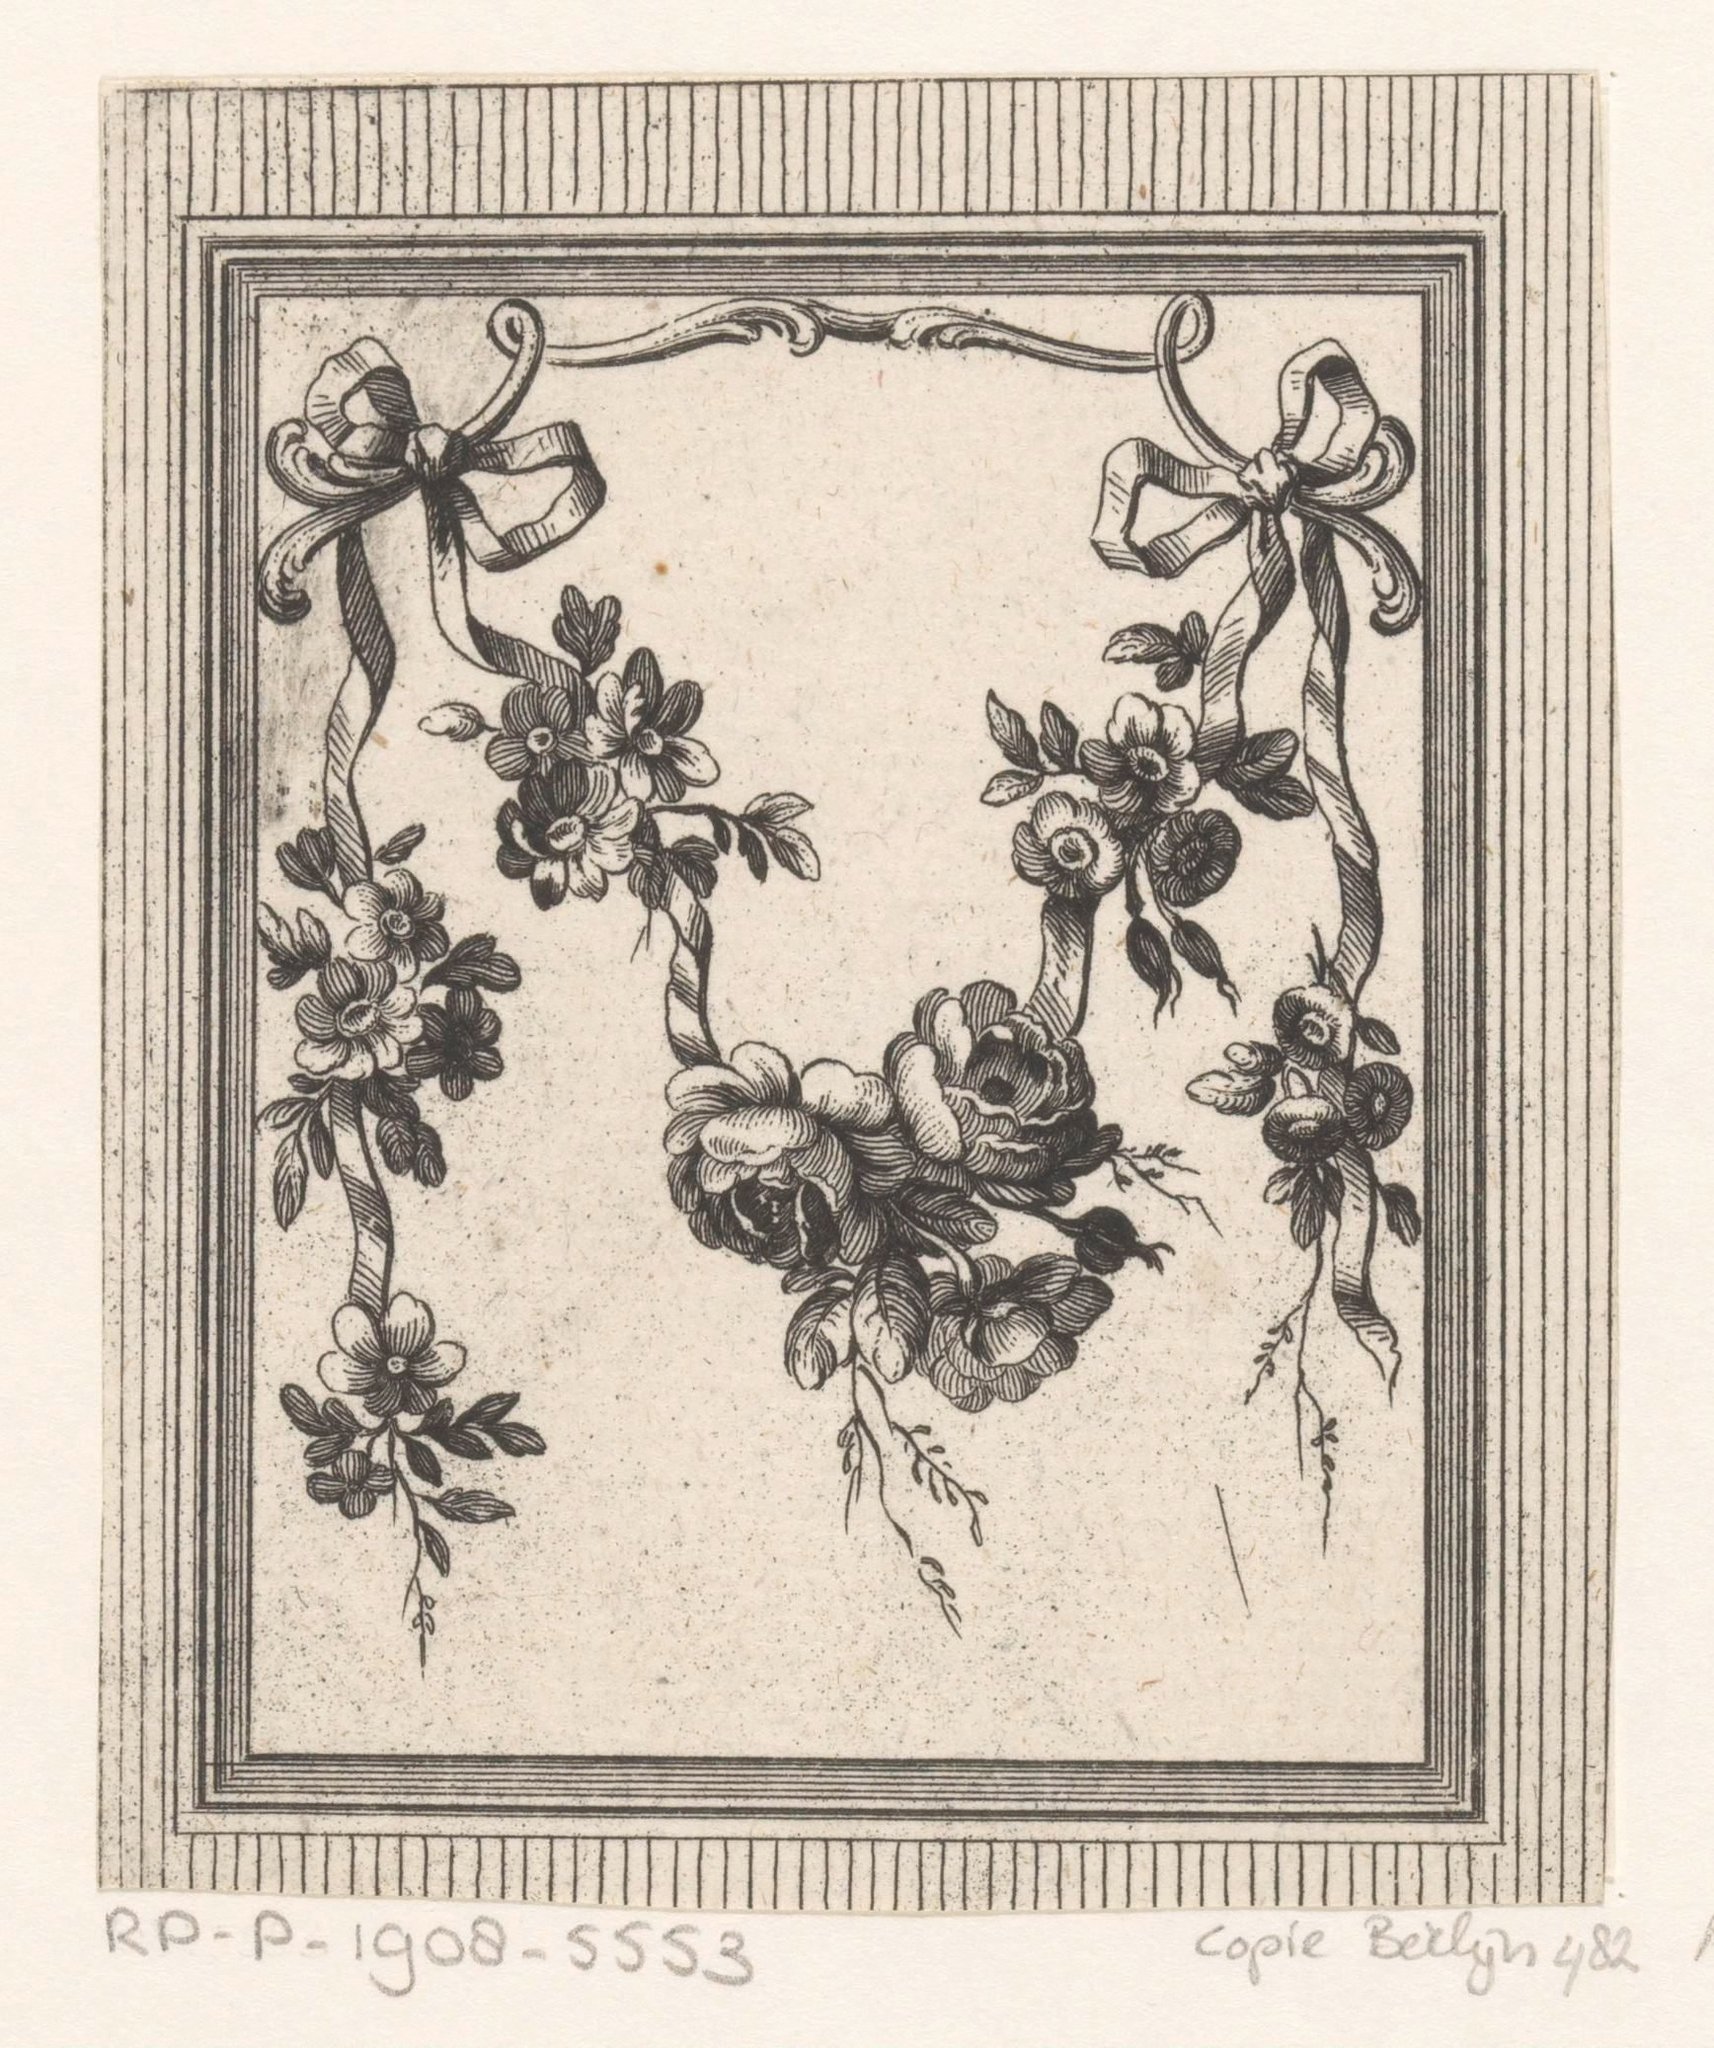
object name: ornament print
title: Bloemguirlande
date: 1746-1775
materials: paper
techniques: etching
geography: augsburg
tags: ornament ~ festoon, garland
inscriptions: collector's mark: Lugt 2228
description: Bovenste deel (links) van kopie naar prent drie van serie Ir Cahier de Groupes de Fleurs et d'Ornemens.